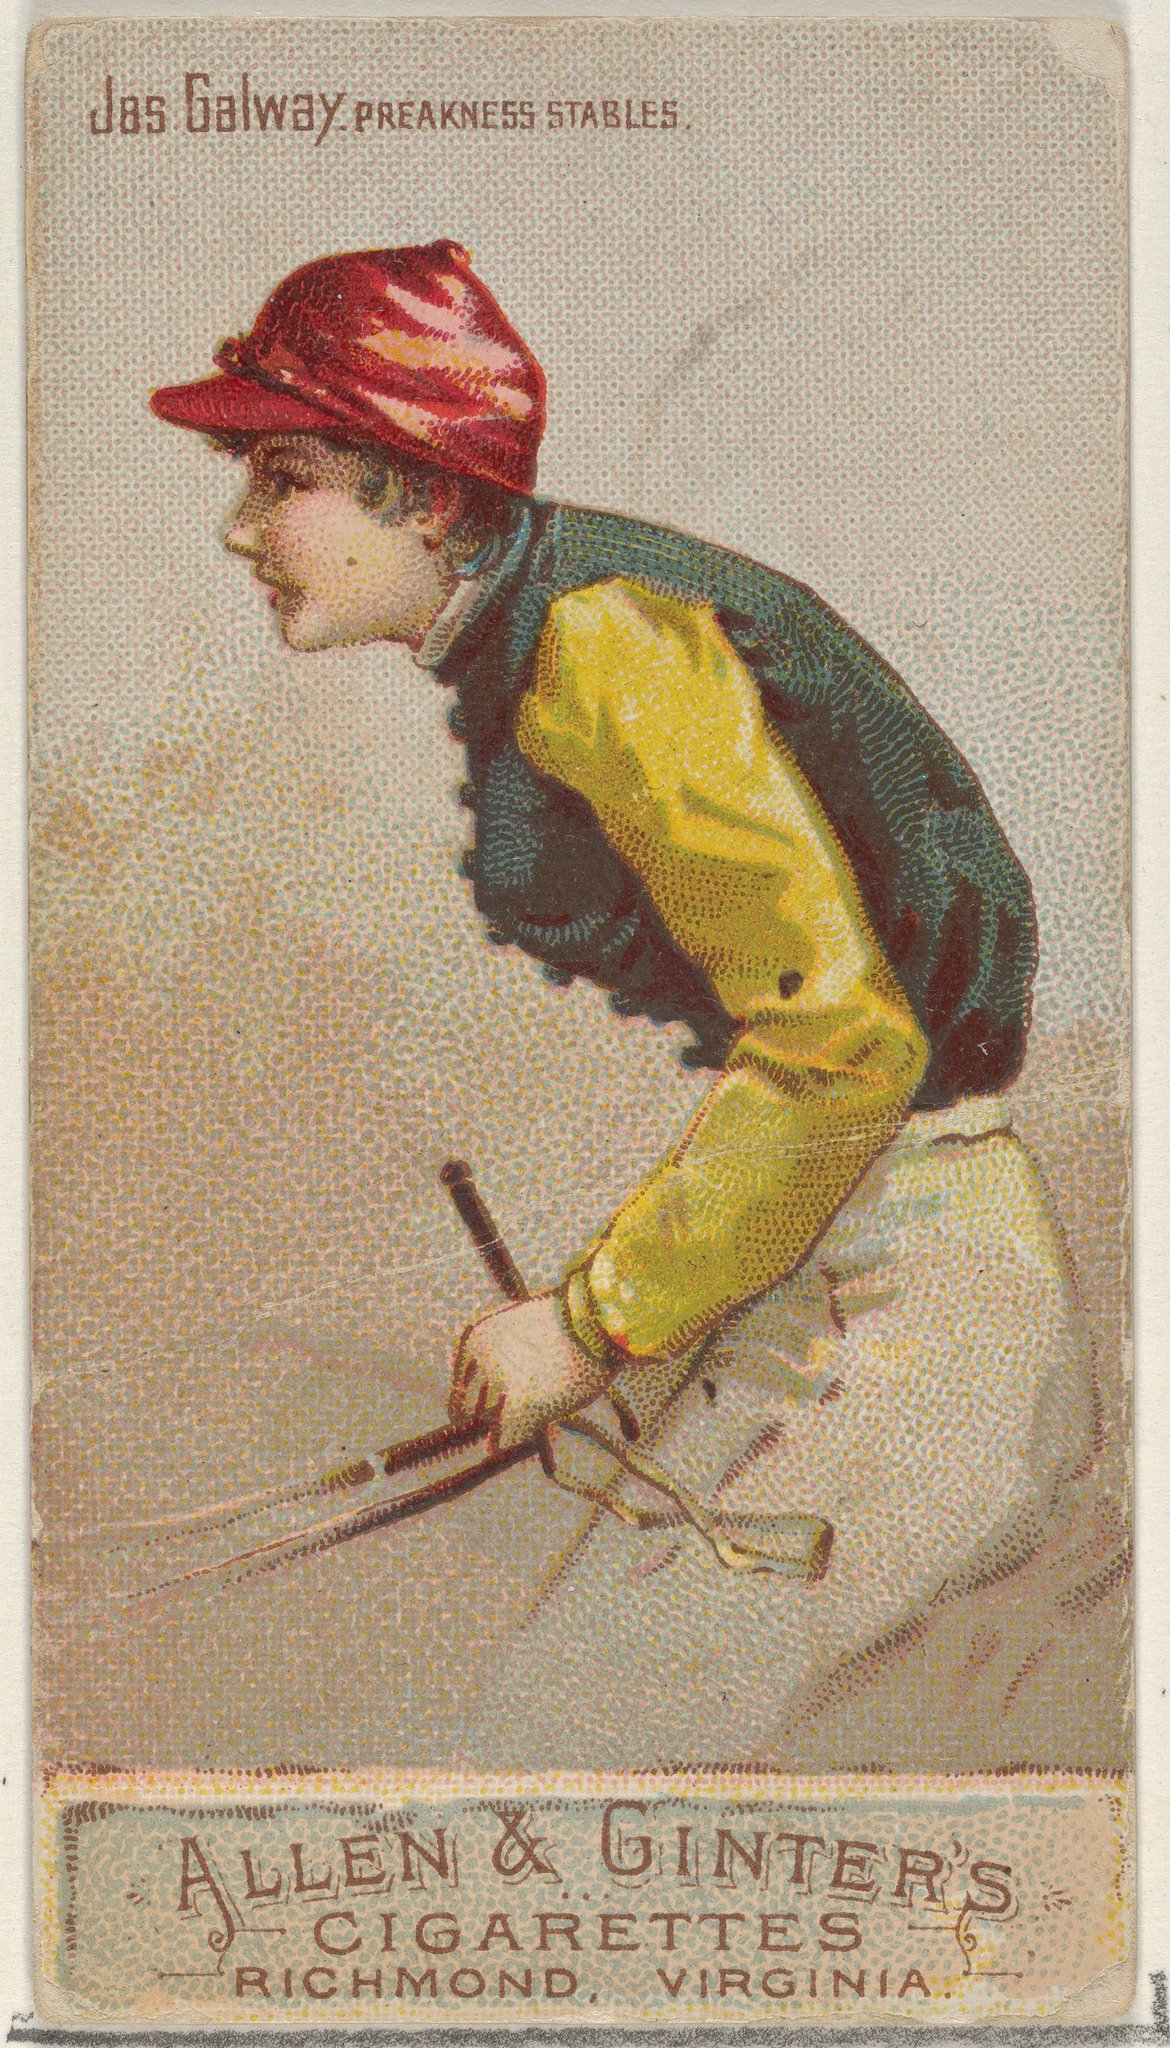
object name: print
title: Jas. Galway, Preakness Stables, from the Racing Colors of the World series (N22b) for Allen & Ginter Cigarettes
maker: allen & ginter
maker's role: publisher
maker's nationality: american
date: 1888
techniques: color lithograph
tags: profiles,women,jockeys